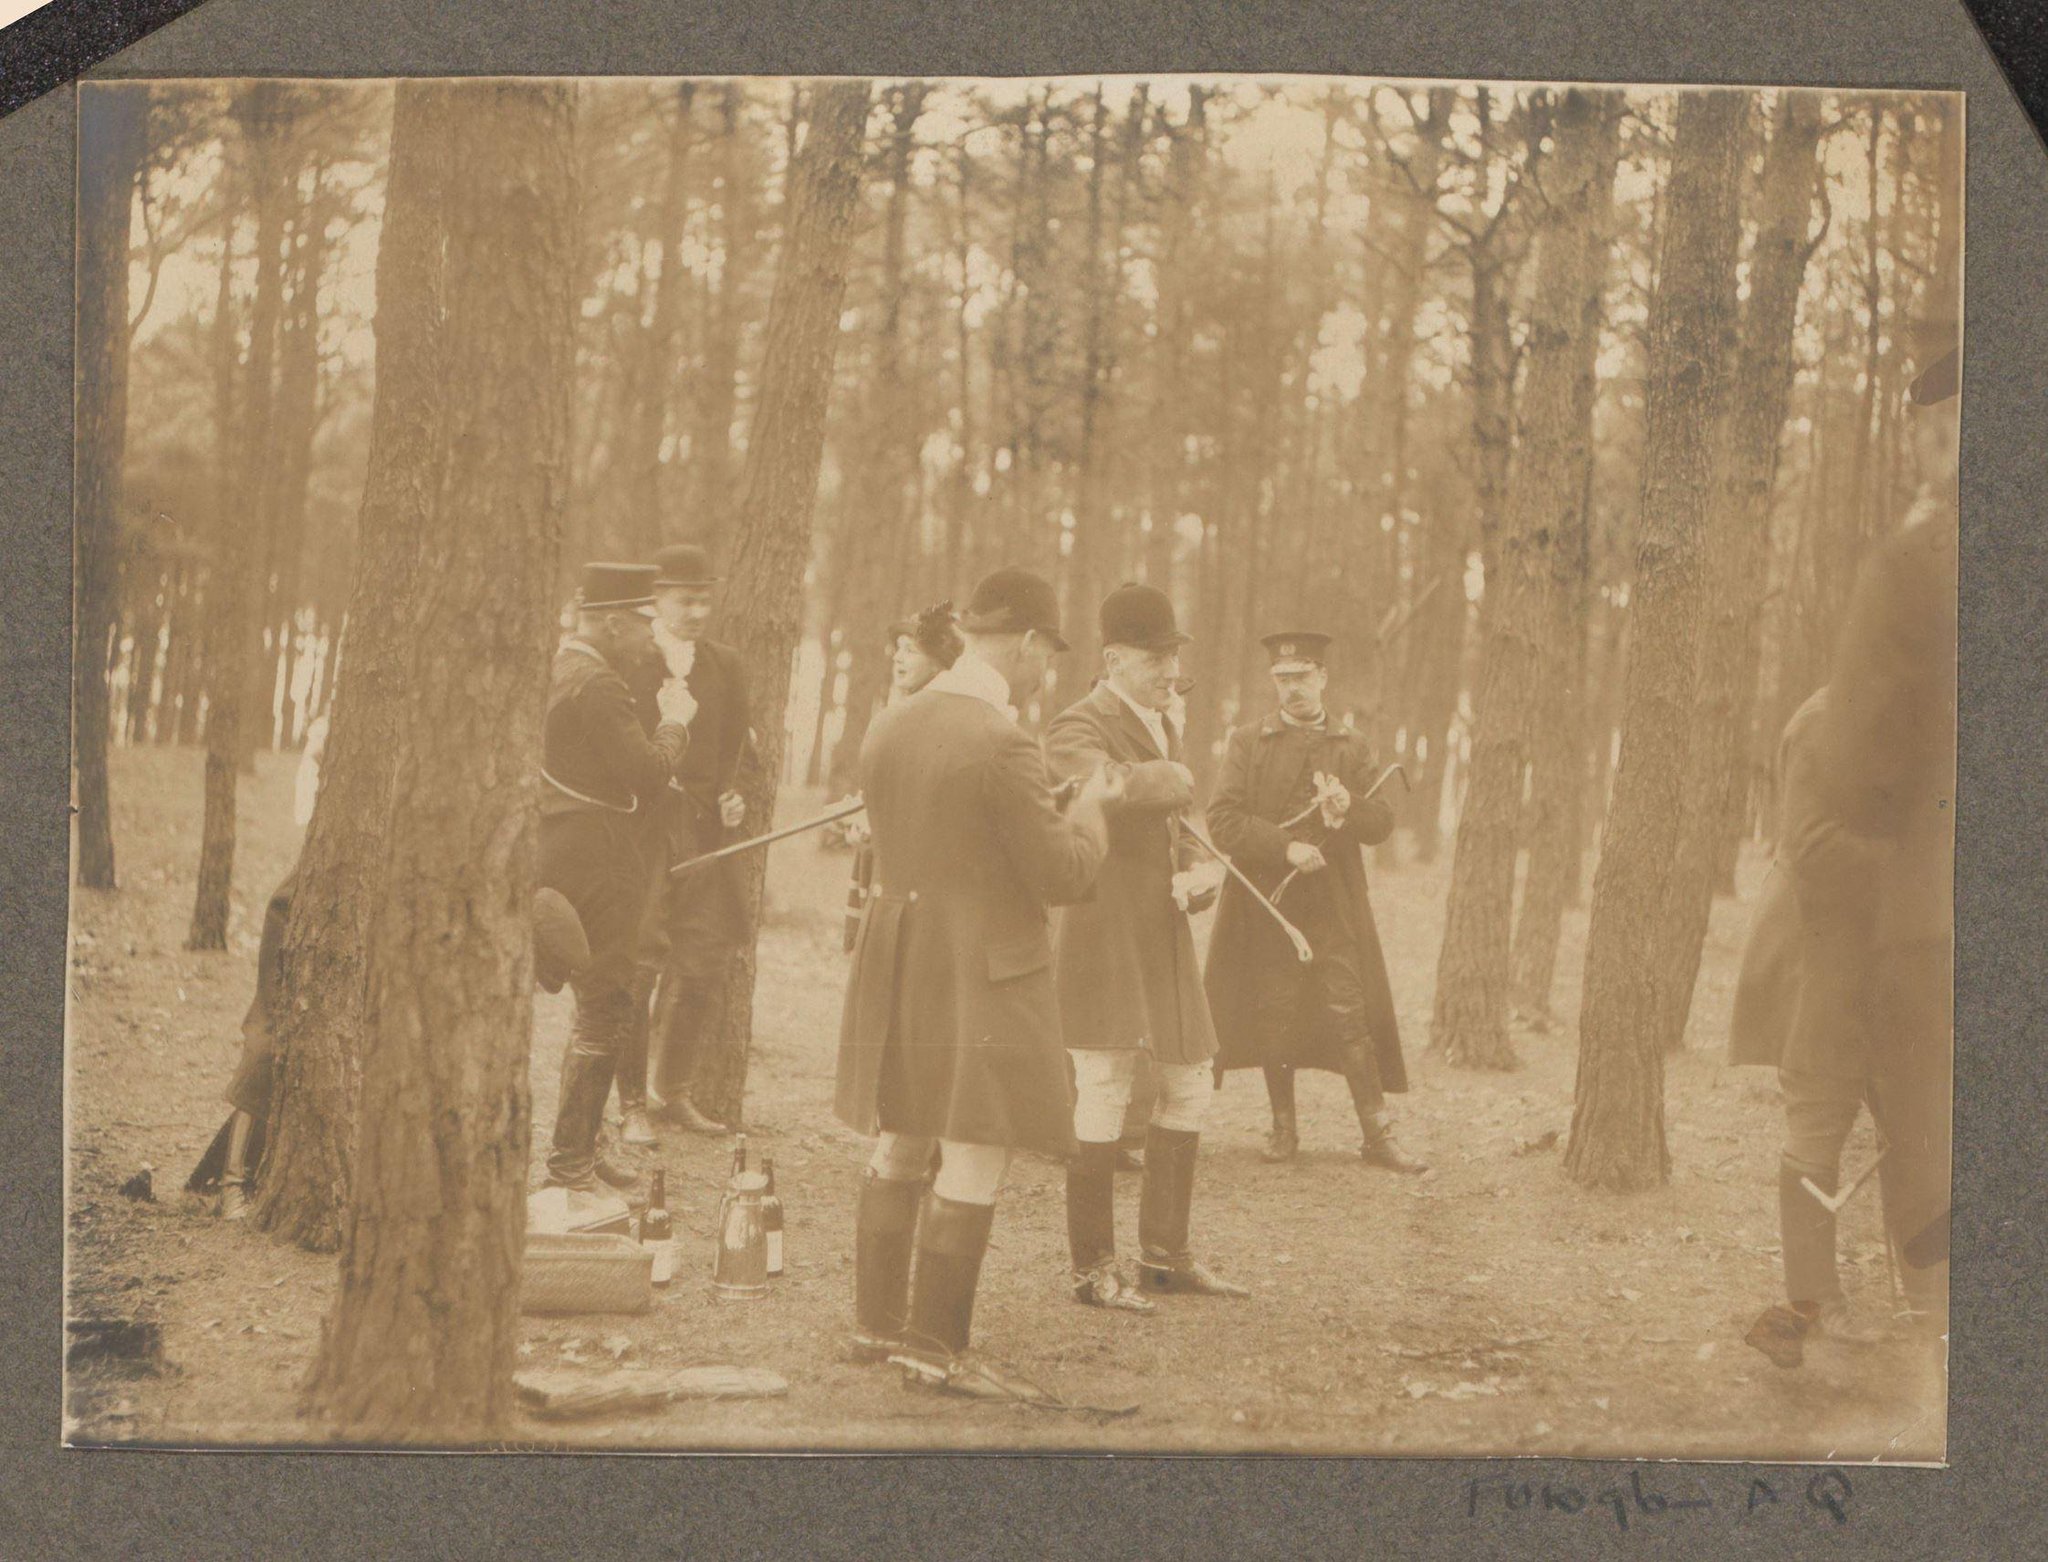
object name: album leaf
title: Ruitertafereel op Koninklijke Houtvesterij Het Loo: ruiters eten en drinken in een bos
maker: Anonymous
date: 1900-1925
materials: photographic support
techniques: gelatin silver print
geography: het loo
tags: hunting, chase, hunting-ground, eating and drinking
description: Onderdeel van Fotoalbum van de heer Brams, opperhoutvester van koningin Wilhelmina op Koninklijke Houtvesterij Het Loo.